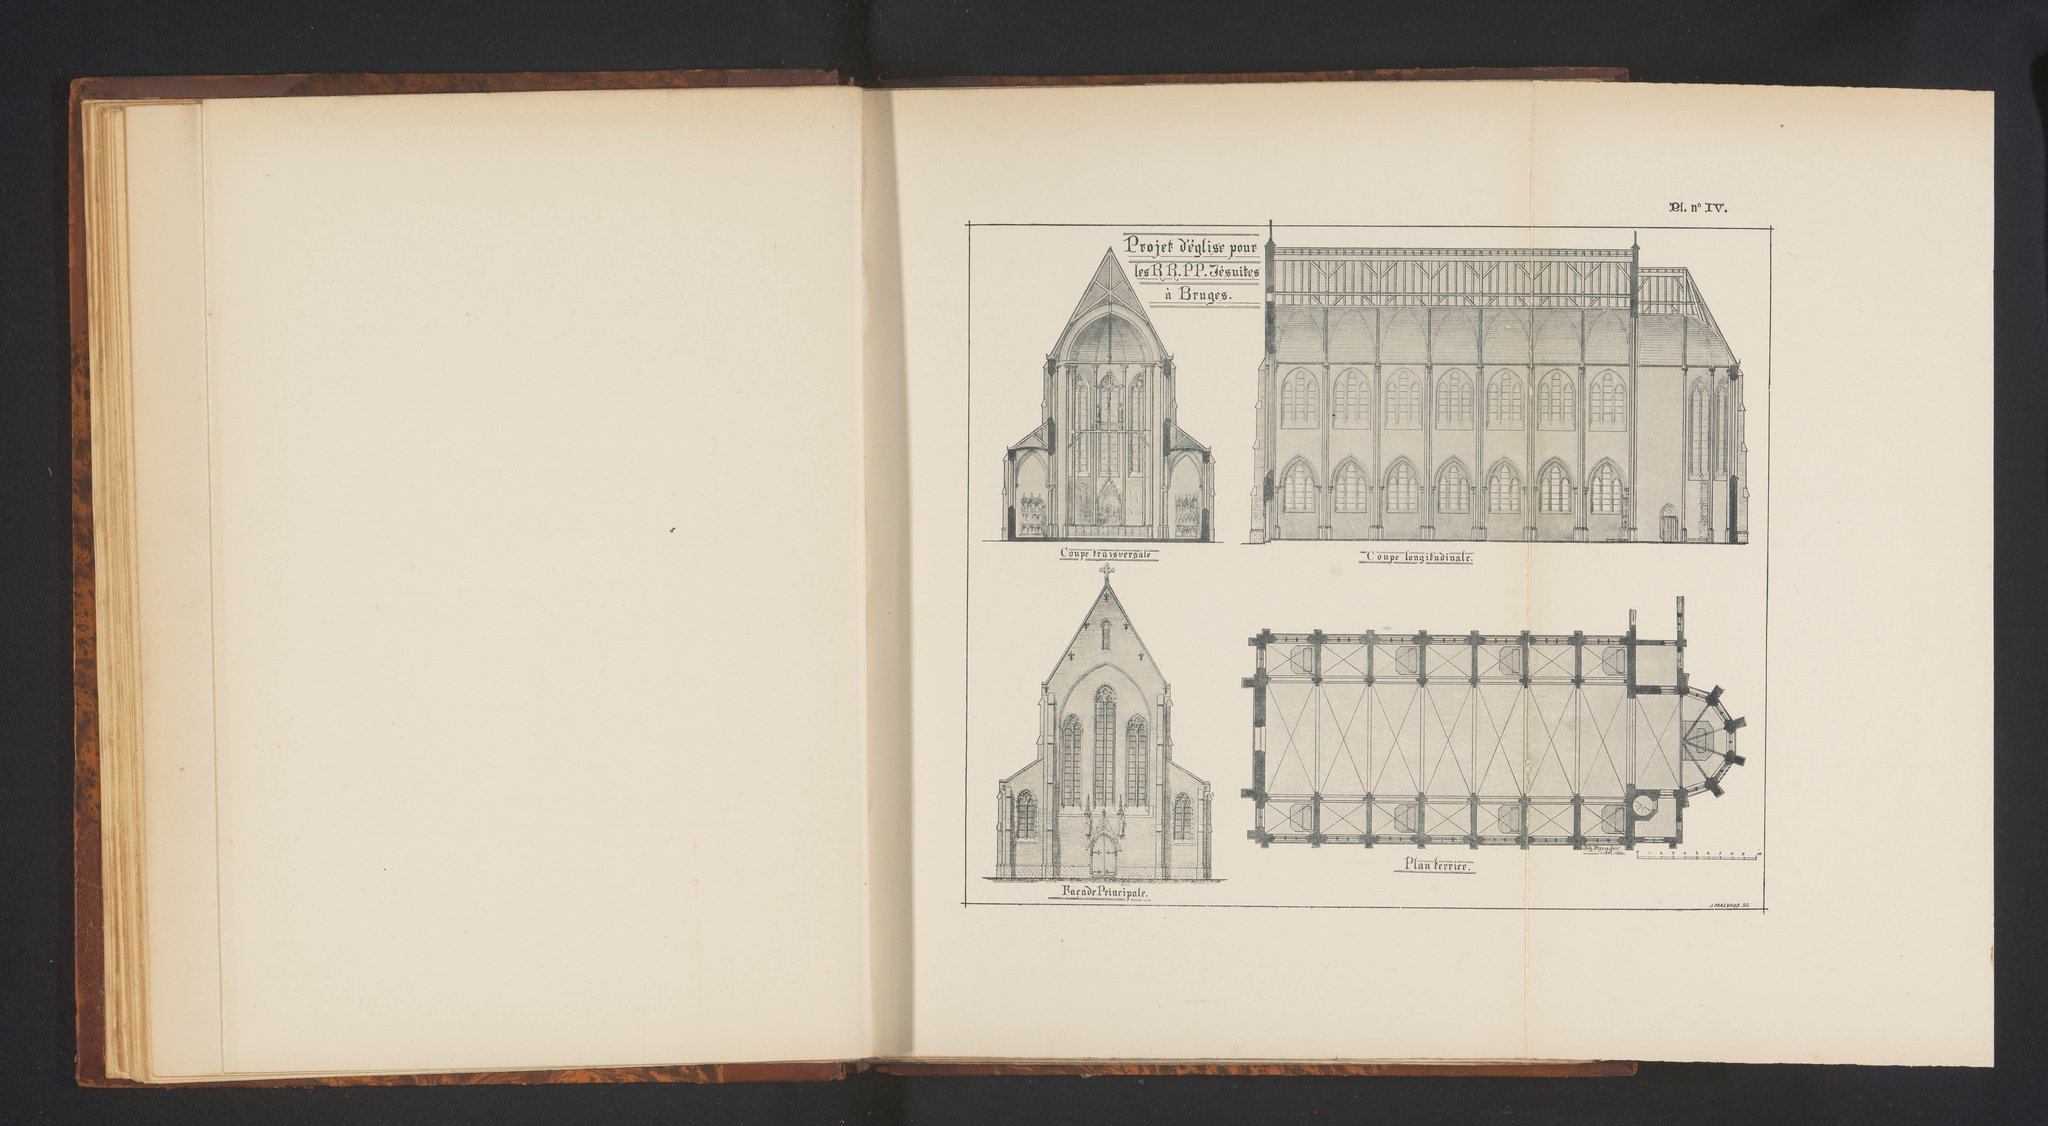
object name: photomechanical print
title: Projet d'église pour les R R.P P. Jésuites à Bruges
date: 1891-1896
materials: paper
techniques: autotype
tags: church (exterior), bruges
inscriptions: number: ‘Pl. no IV.’